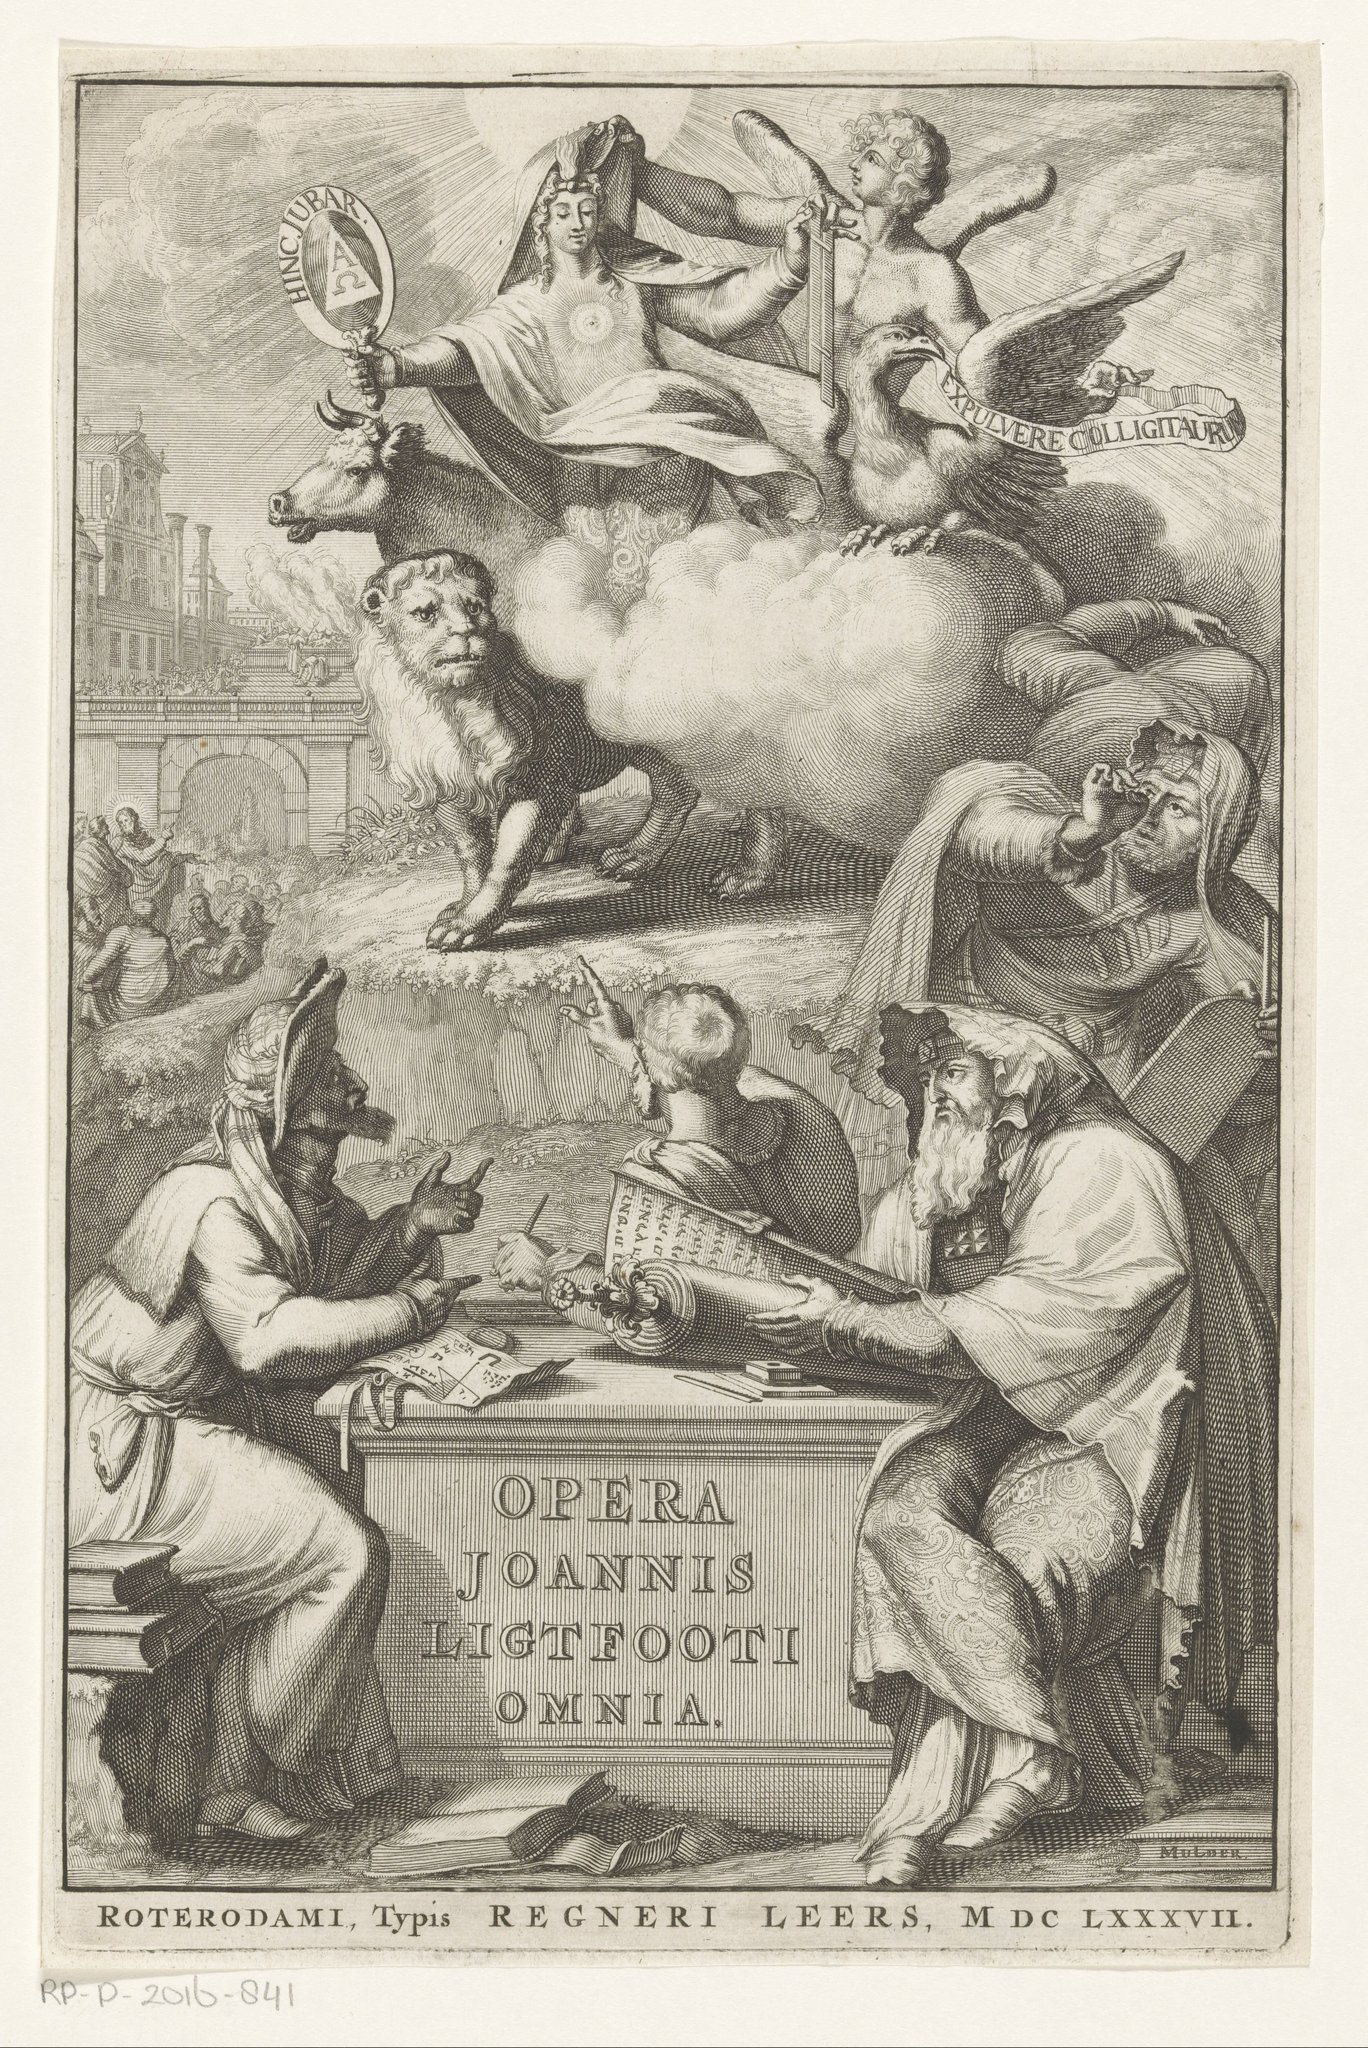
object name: print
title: Allegorische figuur met Joodse man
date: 1686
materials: paper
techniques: etching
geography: rotterdam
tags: truth; 'verità' (ripa), studying the torah, the talmud, etc. ~ personal duties in jewish life, jewish religion and culture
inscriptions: collector's mark: Lugt 2228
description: Bij een voetstuk of stenen tafel zit een joodse man, omringd door drie mannen, met een boekrol waarop Hebreeuwse teksten staan. Op de achtergrond een allegorische figuur (mogelijk Waarheid) omringd door de vier evangelistensymbolen.